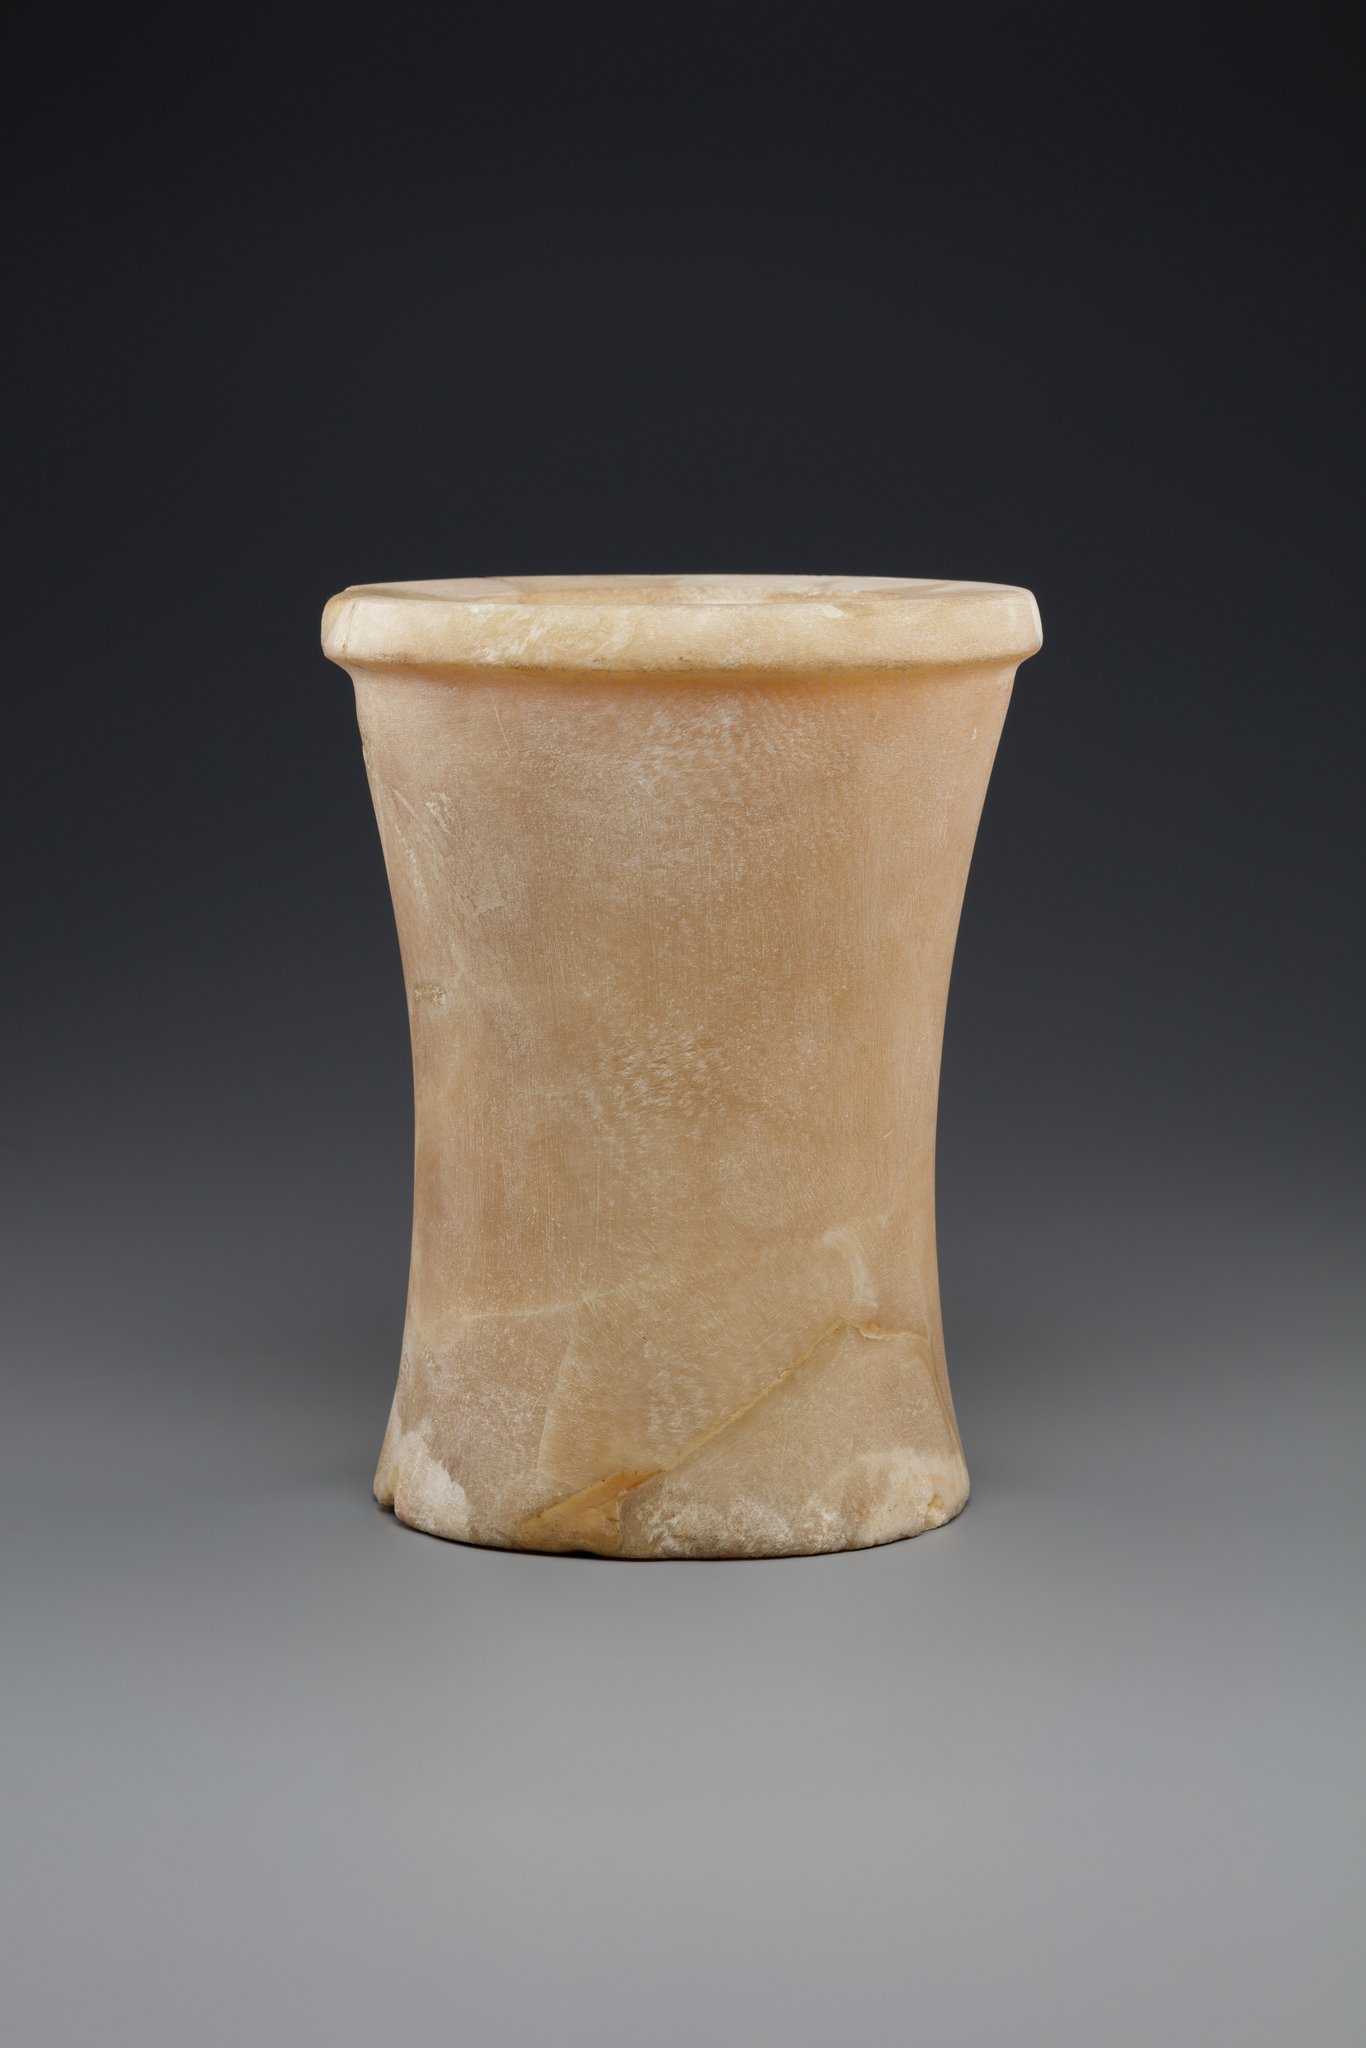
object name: jar, cylindrical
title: Cylinder jar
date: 3100-2649 BCE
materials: stone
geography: egypt